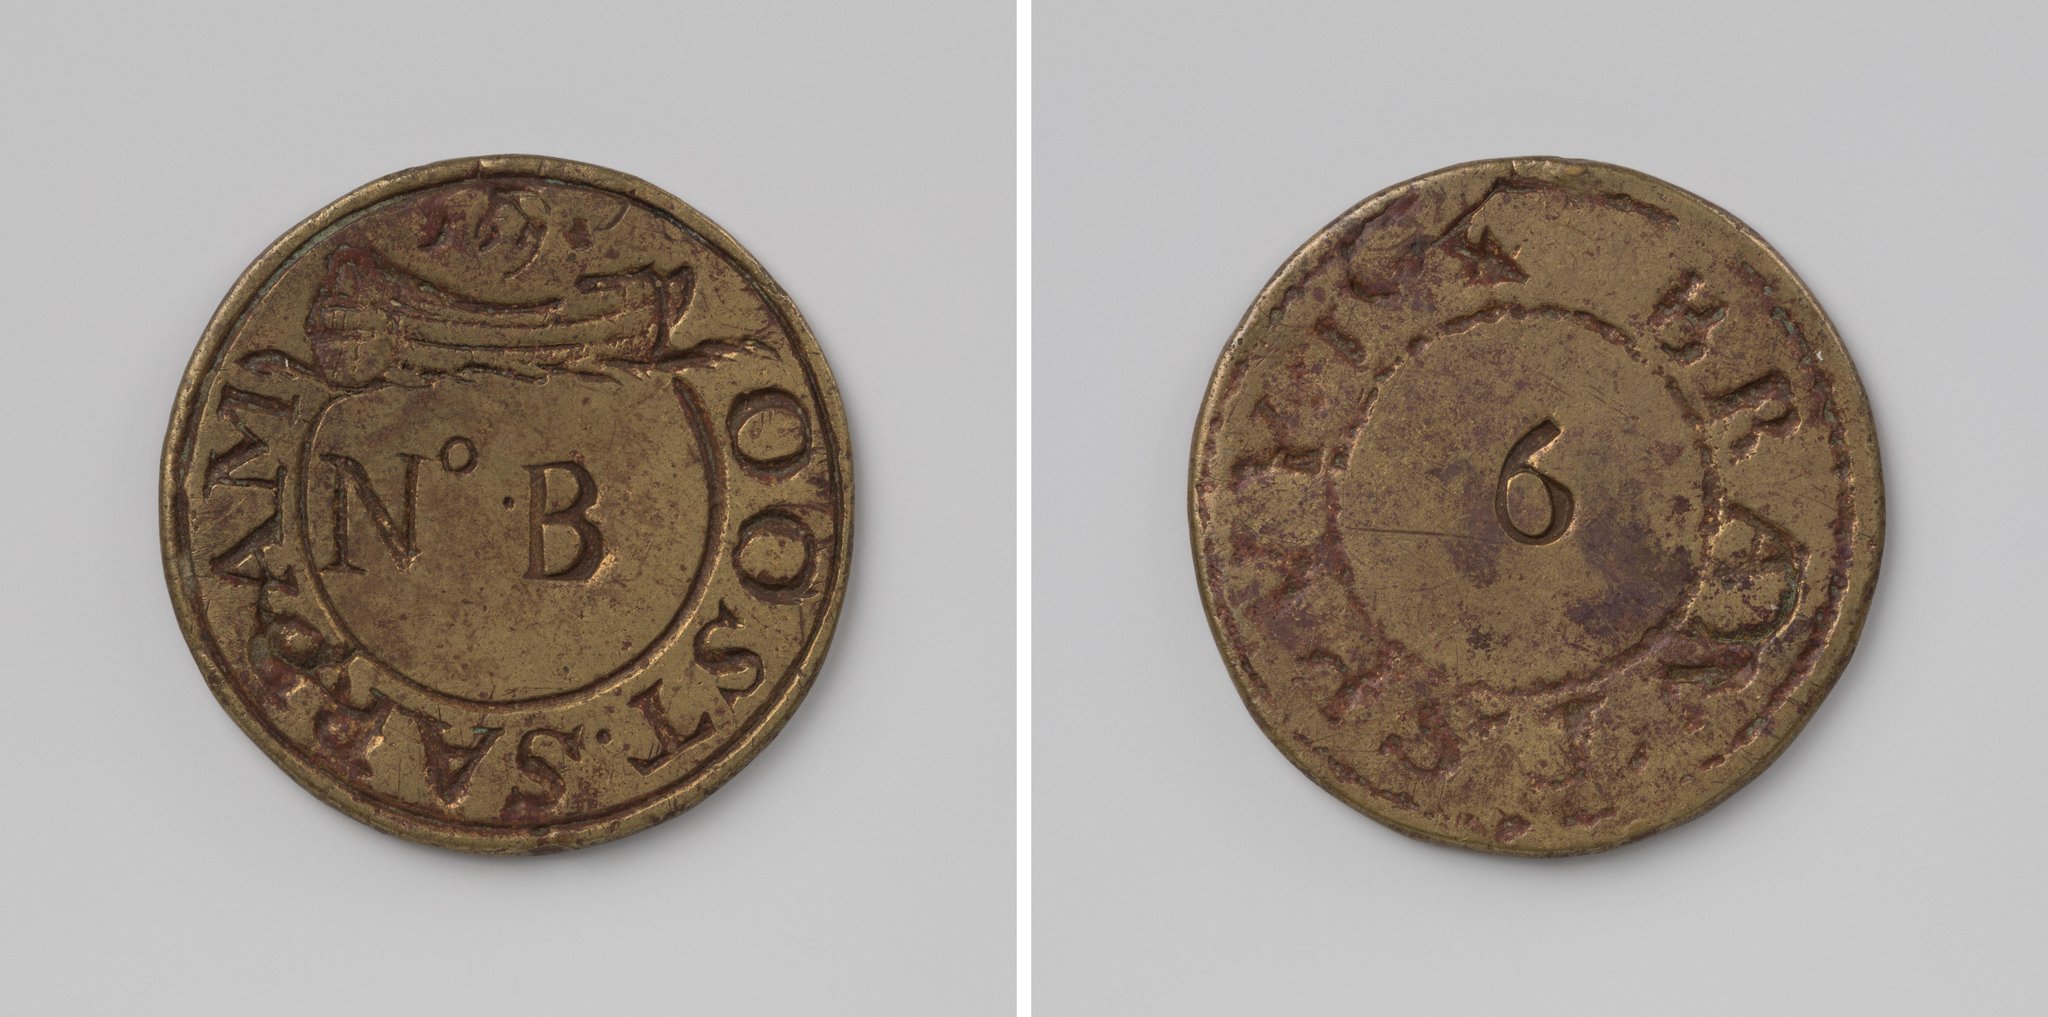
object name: medal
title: Oostzaan, brandspuitpenning met no. 6 en opschrift No. B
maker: Anonymous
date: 1698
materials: brass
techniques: engraving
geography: oostzaan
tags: oostzaan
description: Messing penning. Voorzijde: romp van schip onder jaartal boven opschrift No. B binnen omschrift. Keerzijde: cijfer 6 binnen omschrift